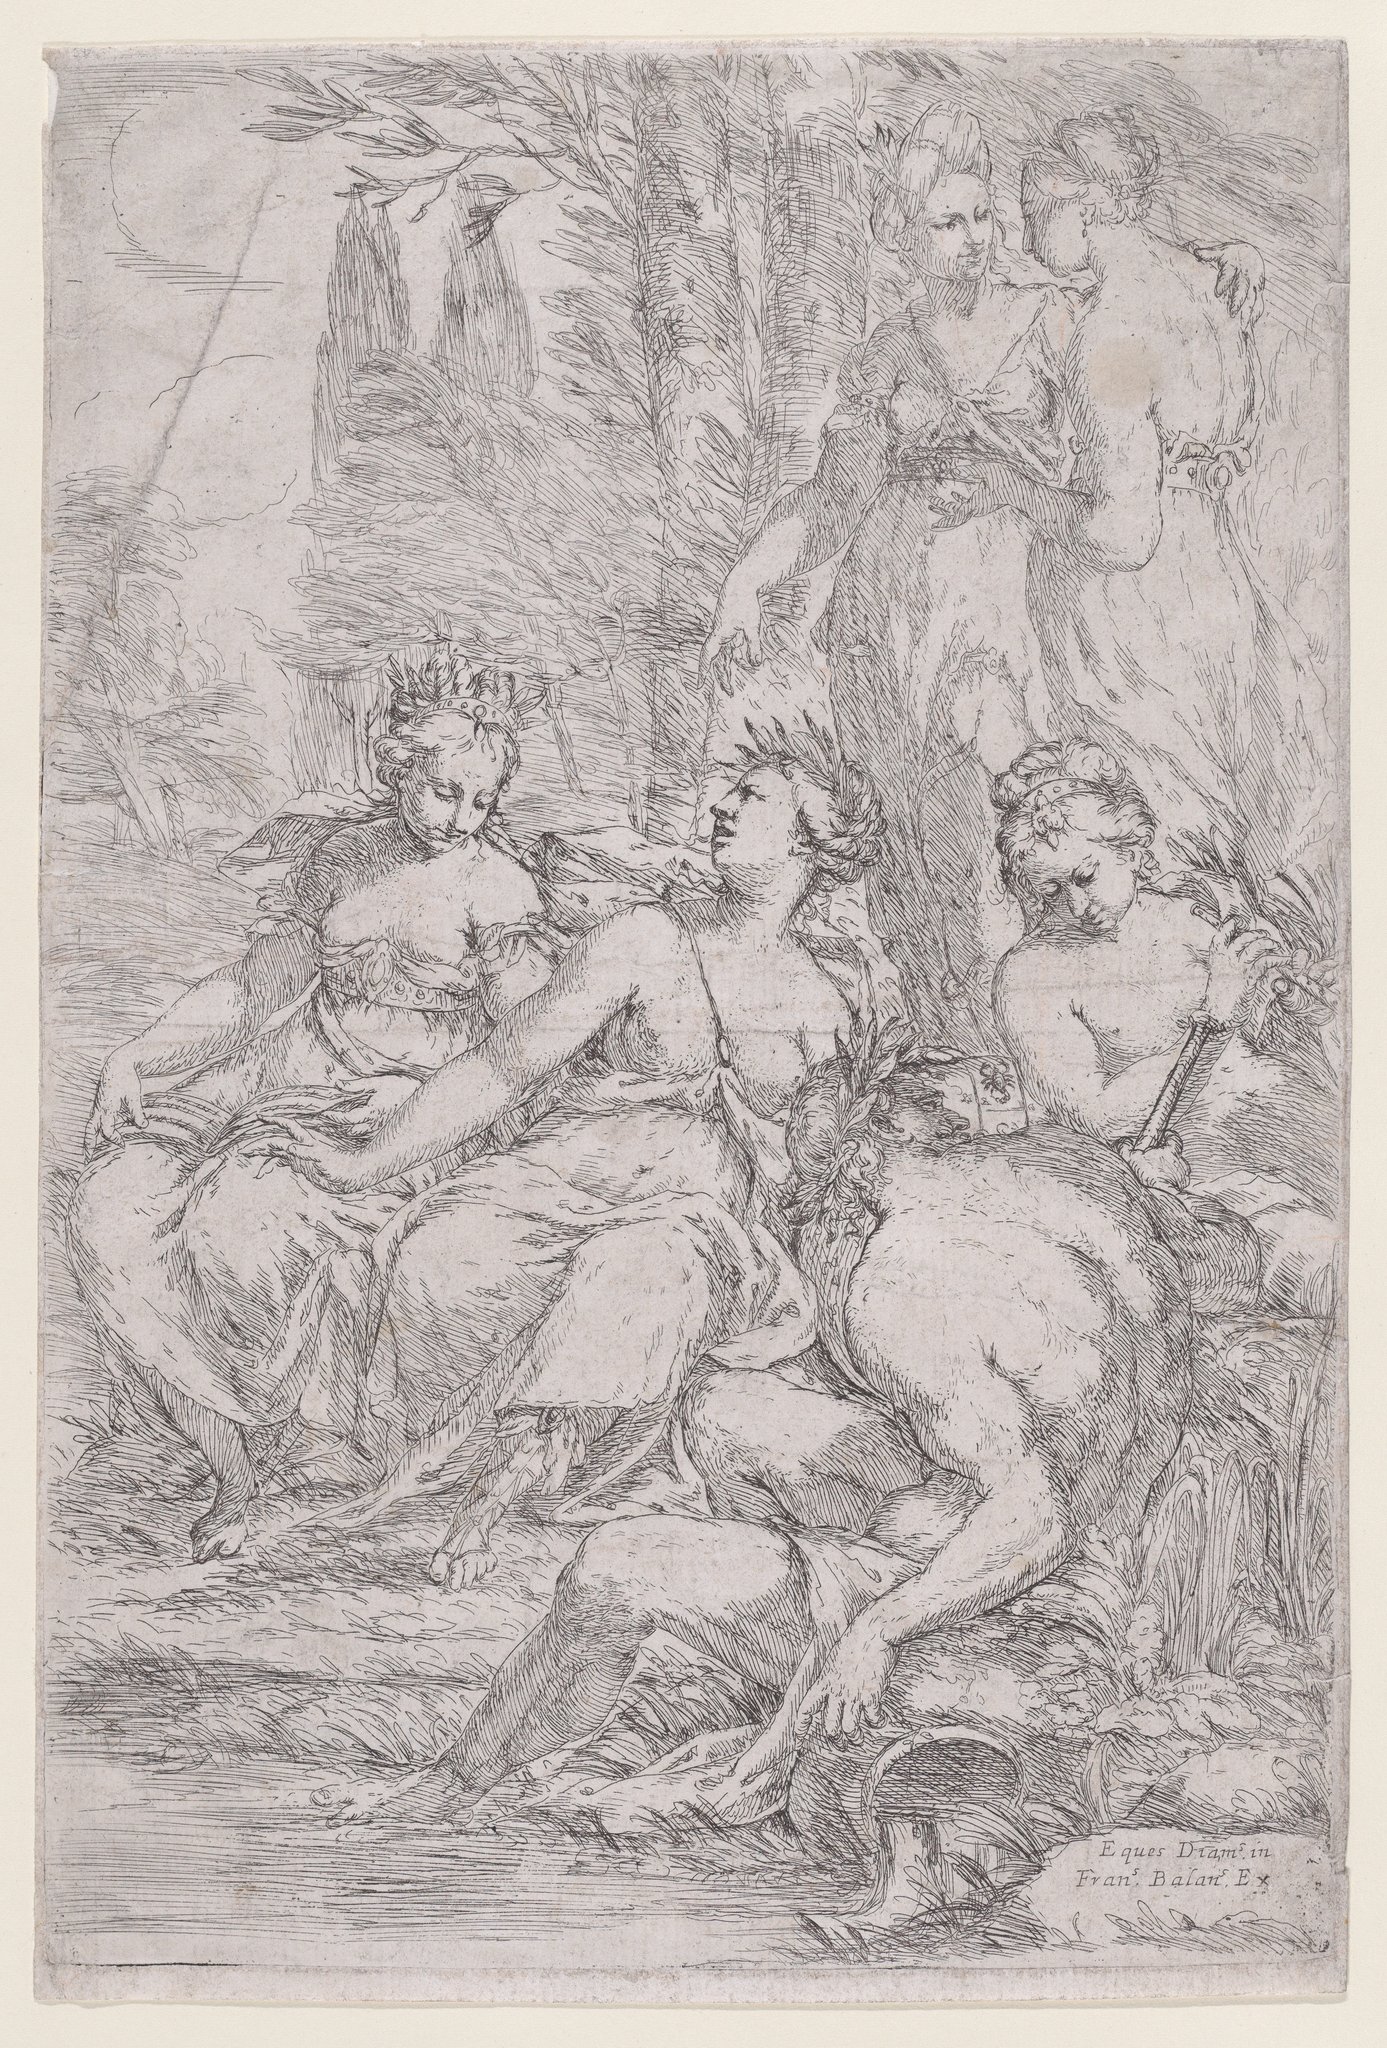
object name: print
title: Five muses and a seated river god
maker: giuseppe diamantini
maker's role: artist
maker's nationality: italian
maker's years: 1621-1705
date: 1650-1700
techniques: etching